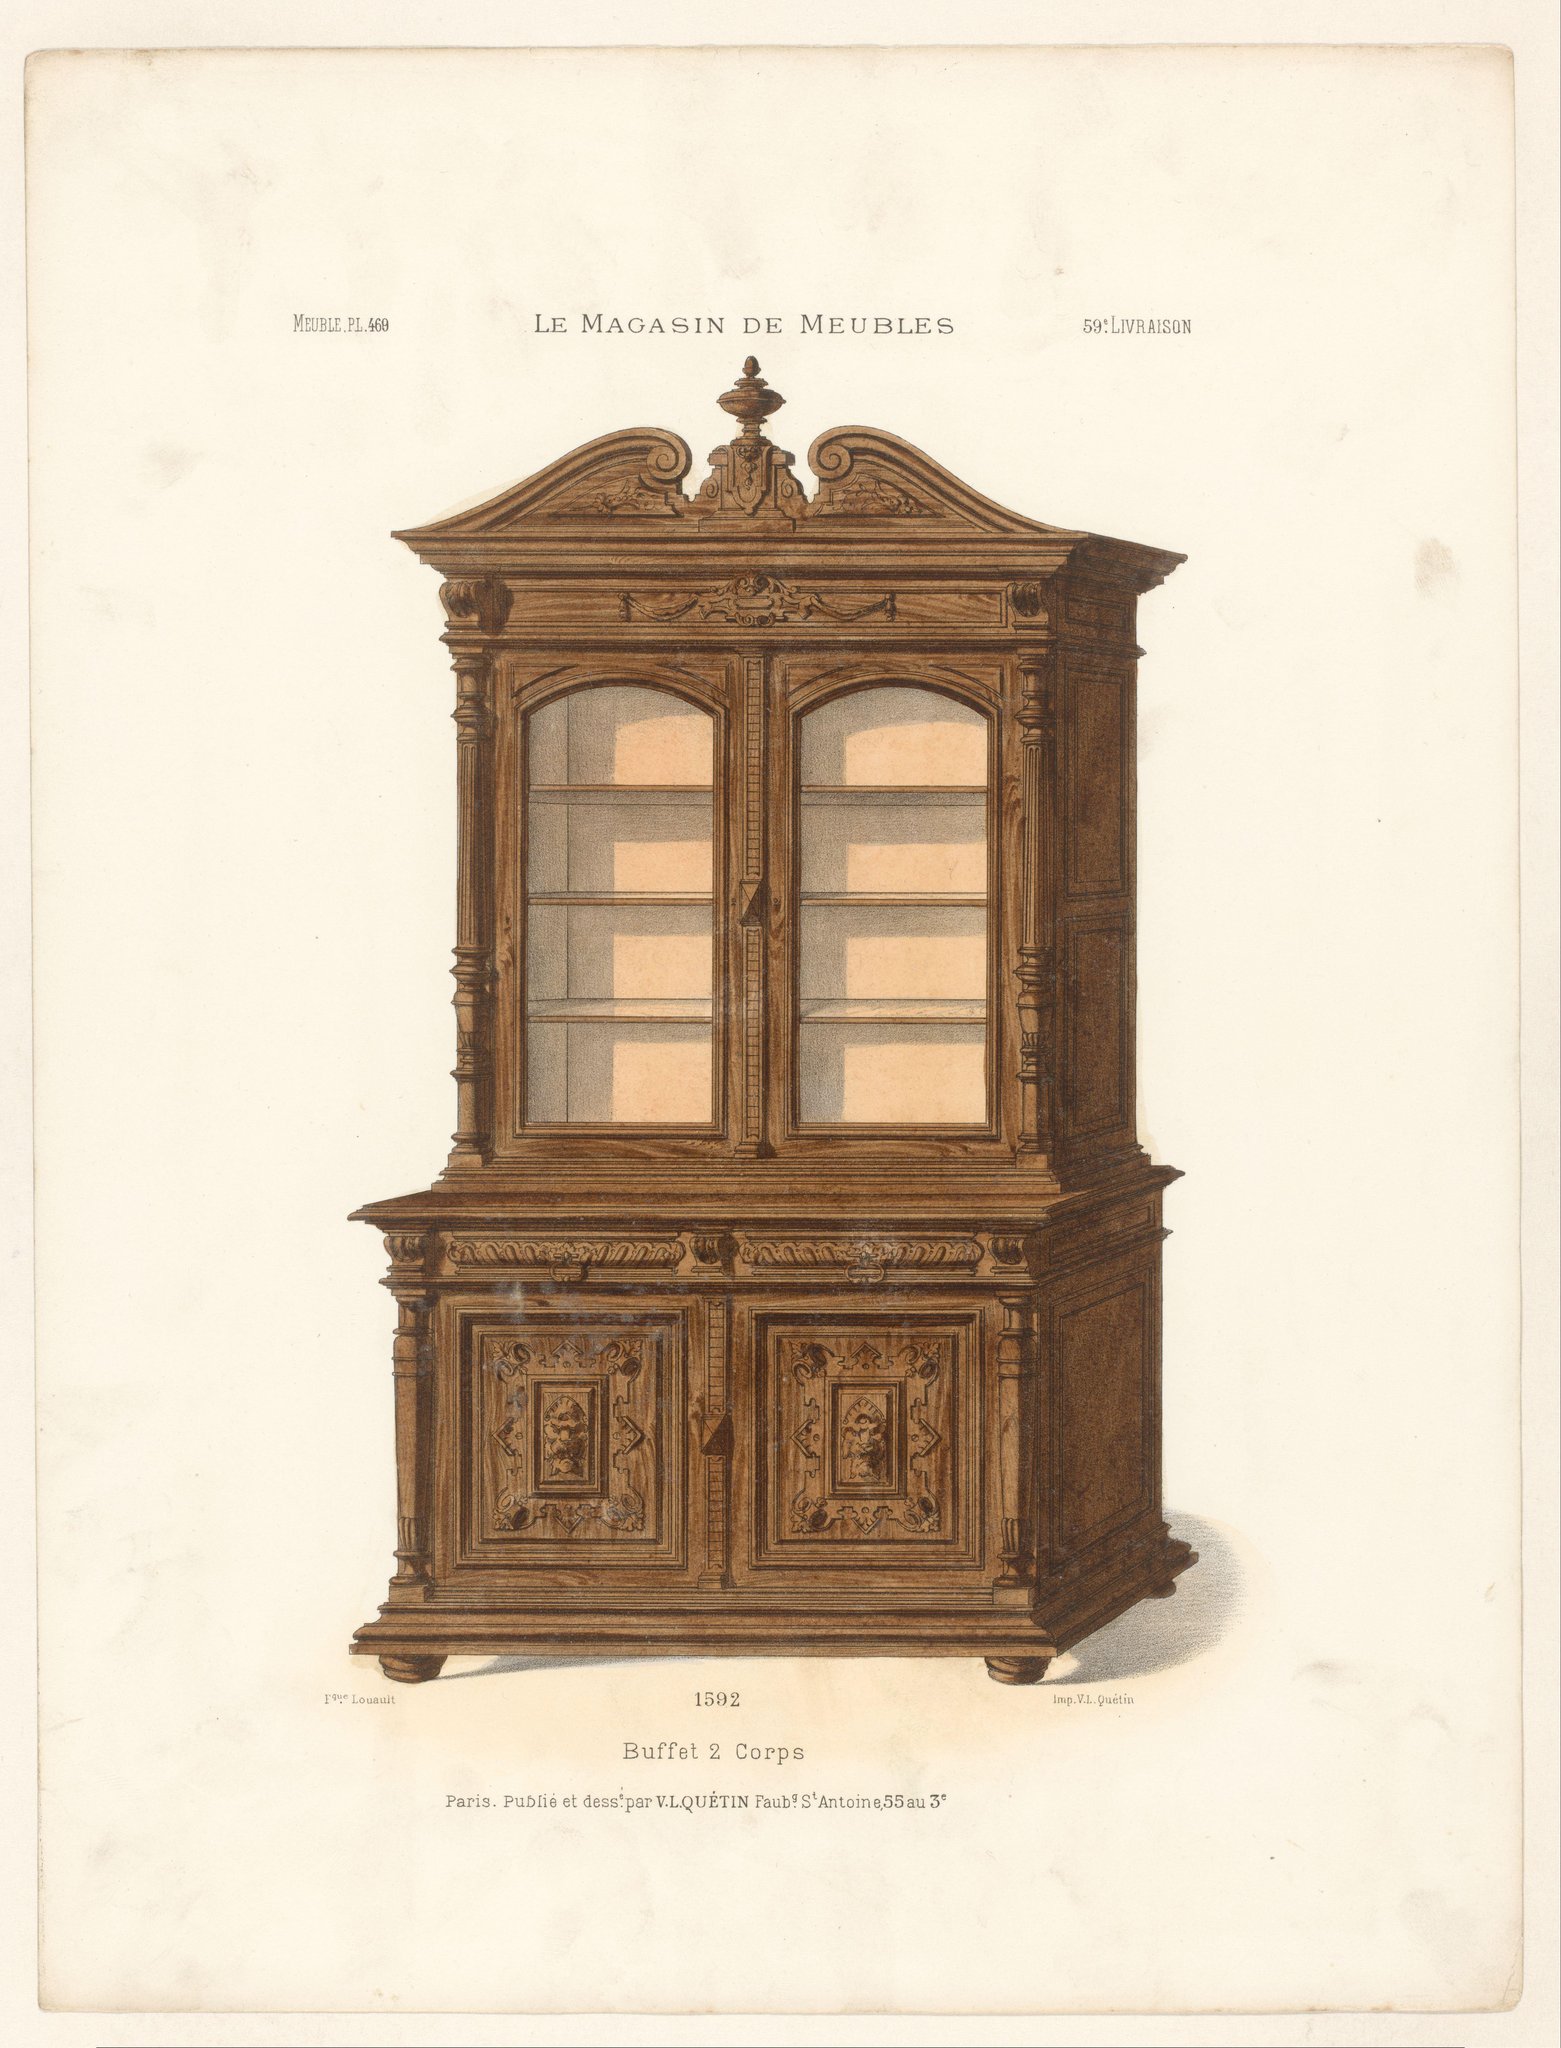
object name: print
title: Le Magasin de Meubles / Meuble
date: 1878-1904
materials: paper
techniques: hand coloring, lithograph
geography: paris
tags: furniture for storage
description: Een buffetkast. Prent uit 59e Livraison.